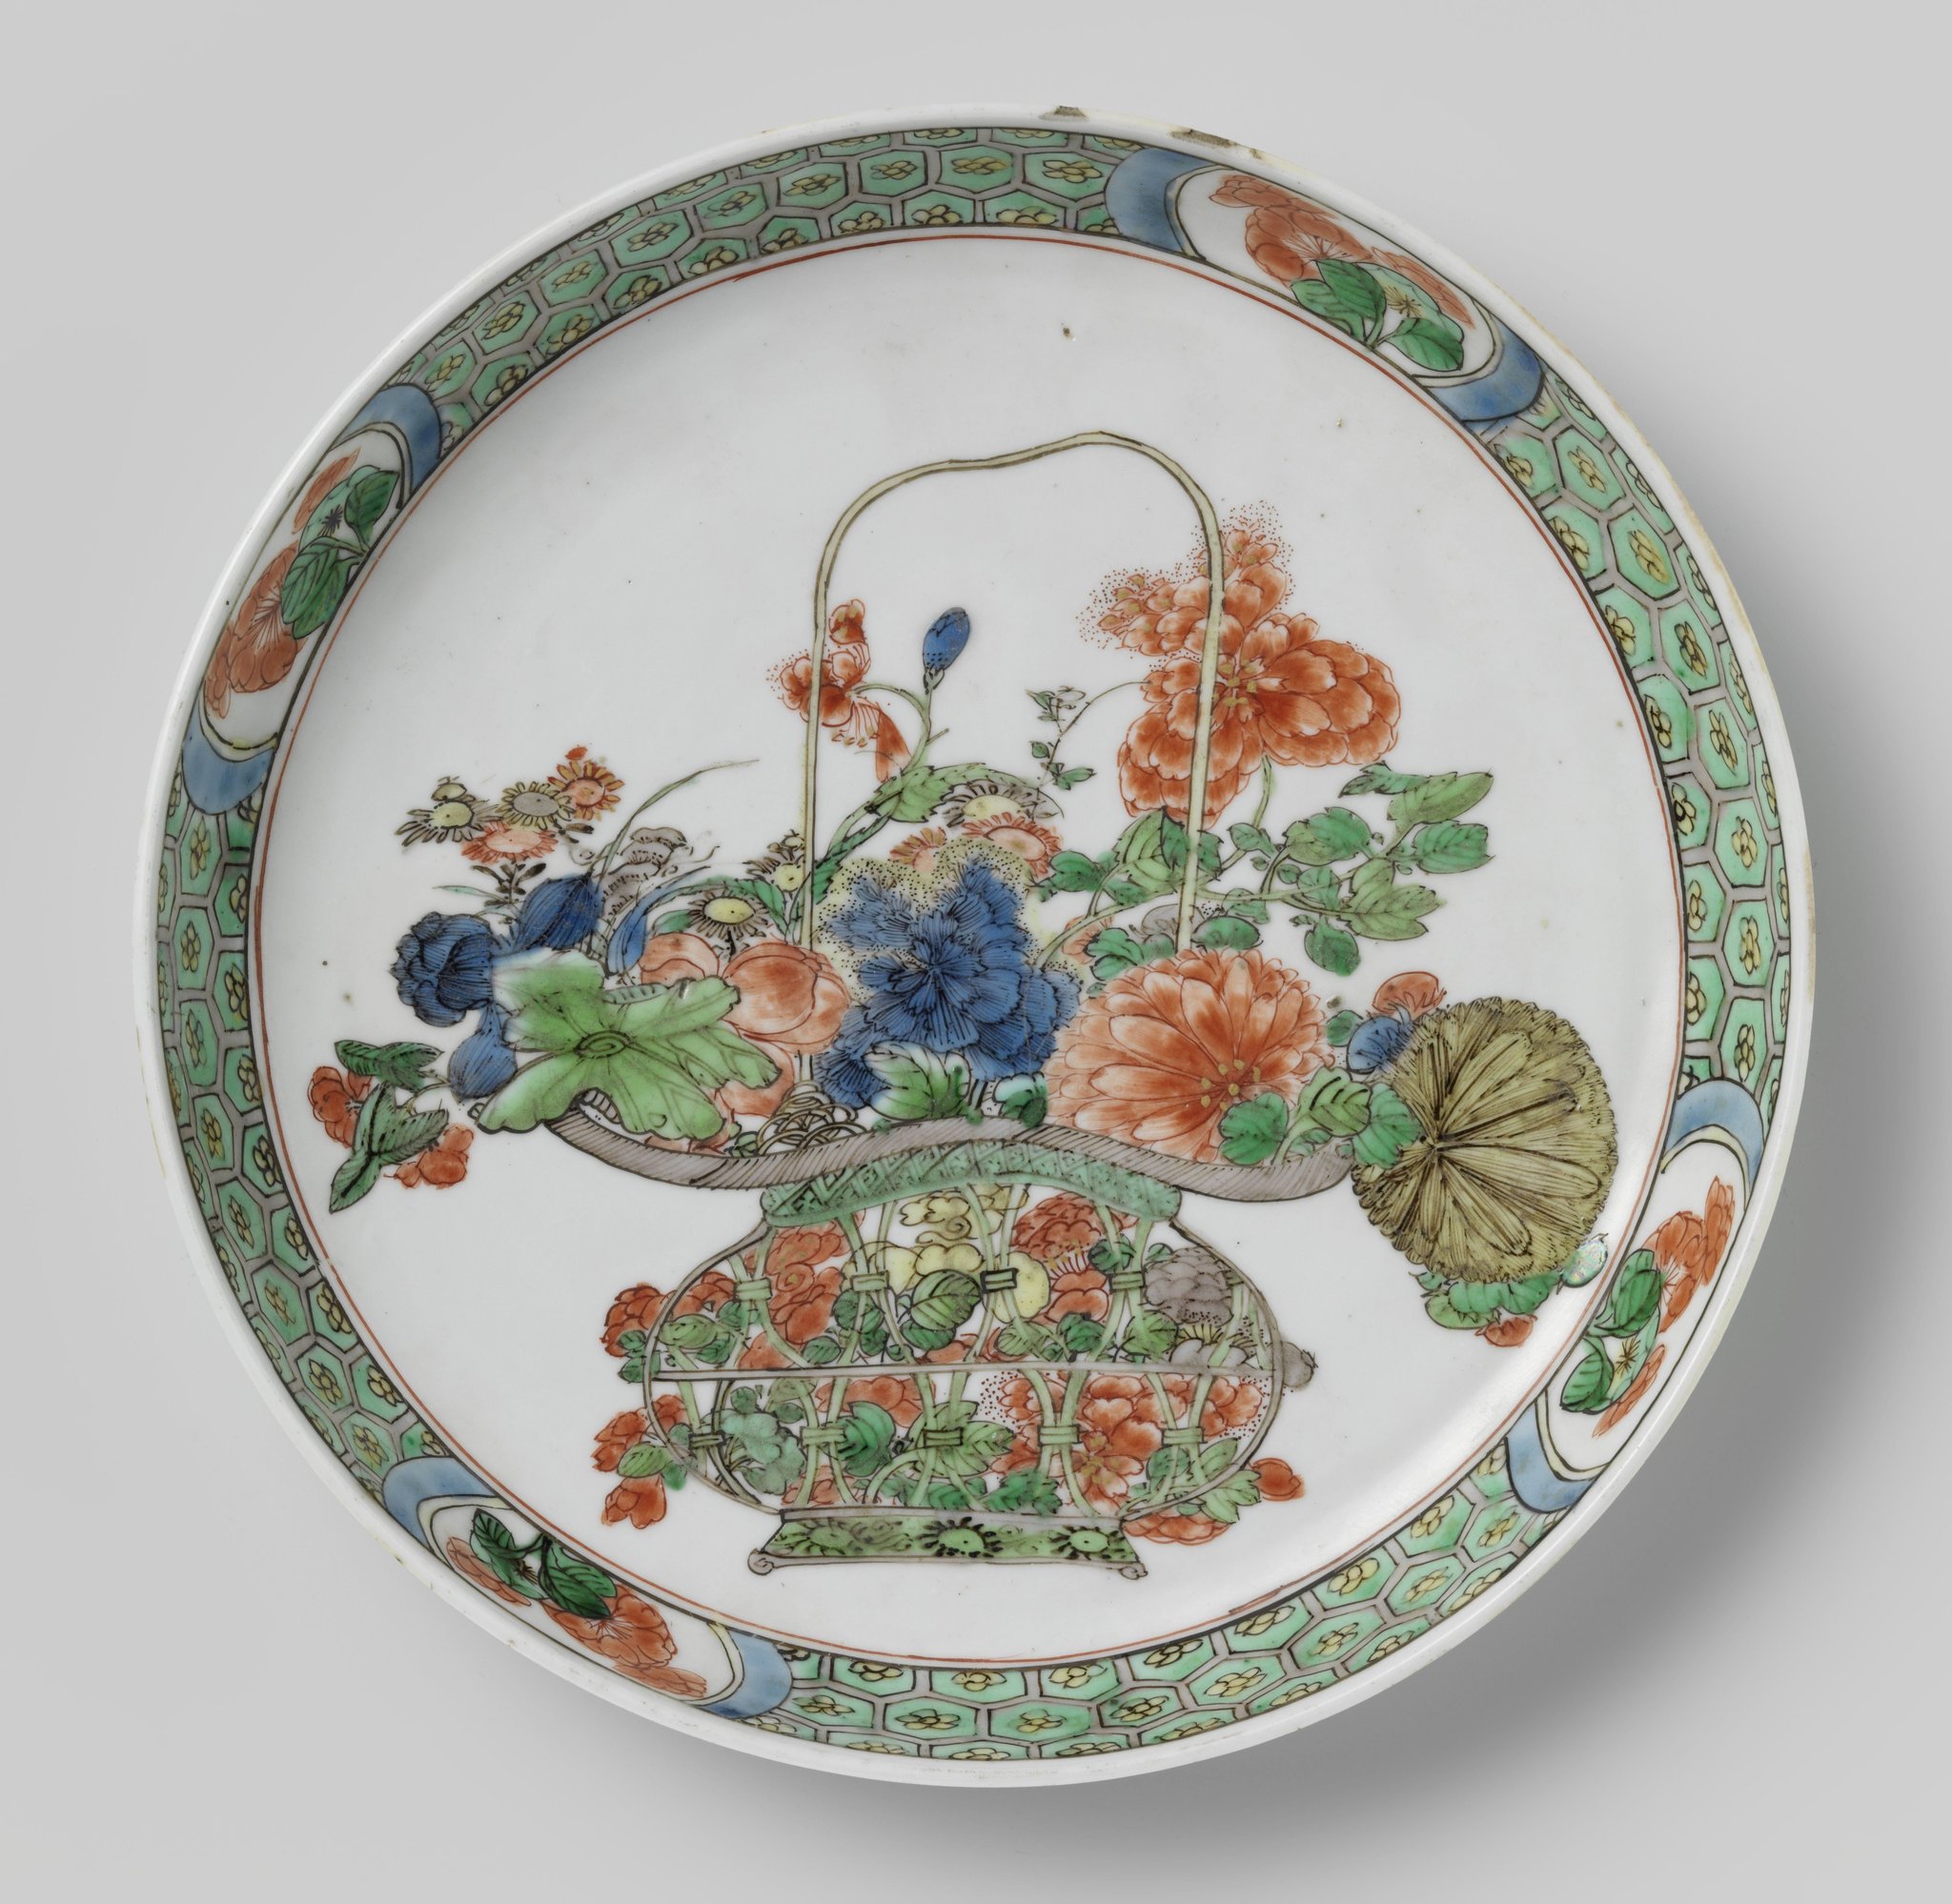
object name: dish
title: Saucer-dish with flower basket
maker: Anonymous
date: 1700-1724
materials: glaze, paint, porcelain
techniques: firing, turning, vitrification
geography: china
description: Schaal van porselein, beschilderd op het glazuur in blauw, rood, groen, geel, aubergine en zwart. Op het plat een bloemenmand met pioen, lotus, Japanse aster en chrysant; op de wand servetwerk afgewisseld met pioentakken in cartouches. Twee chips in de rand. Famille verte.